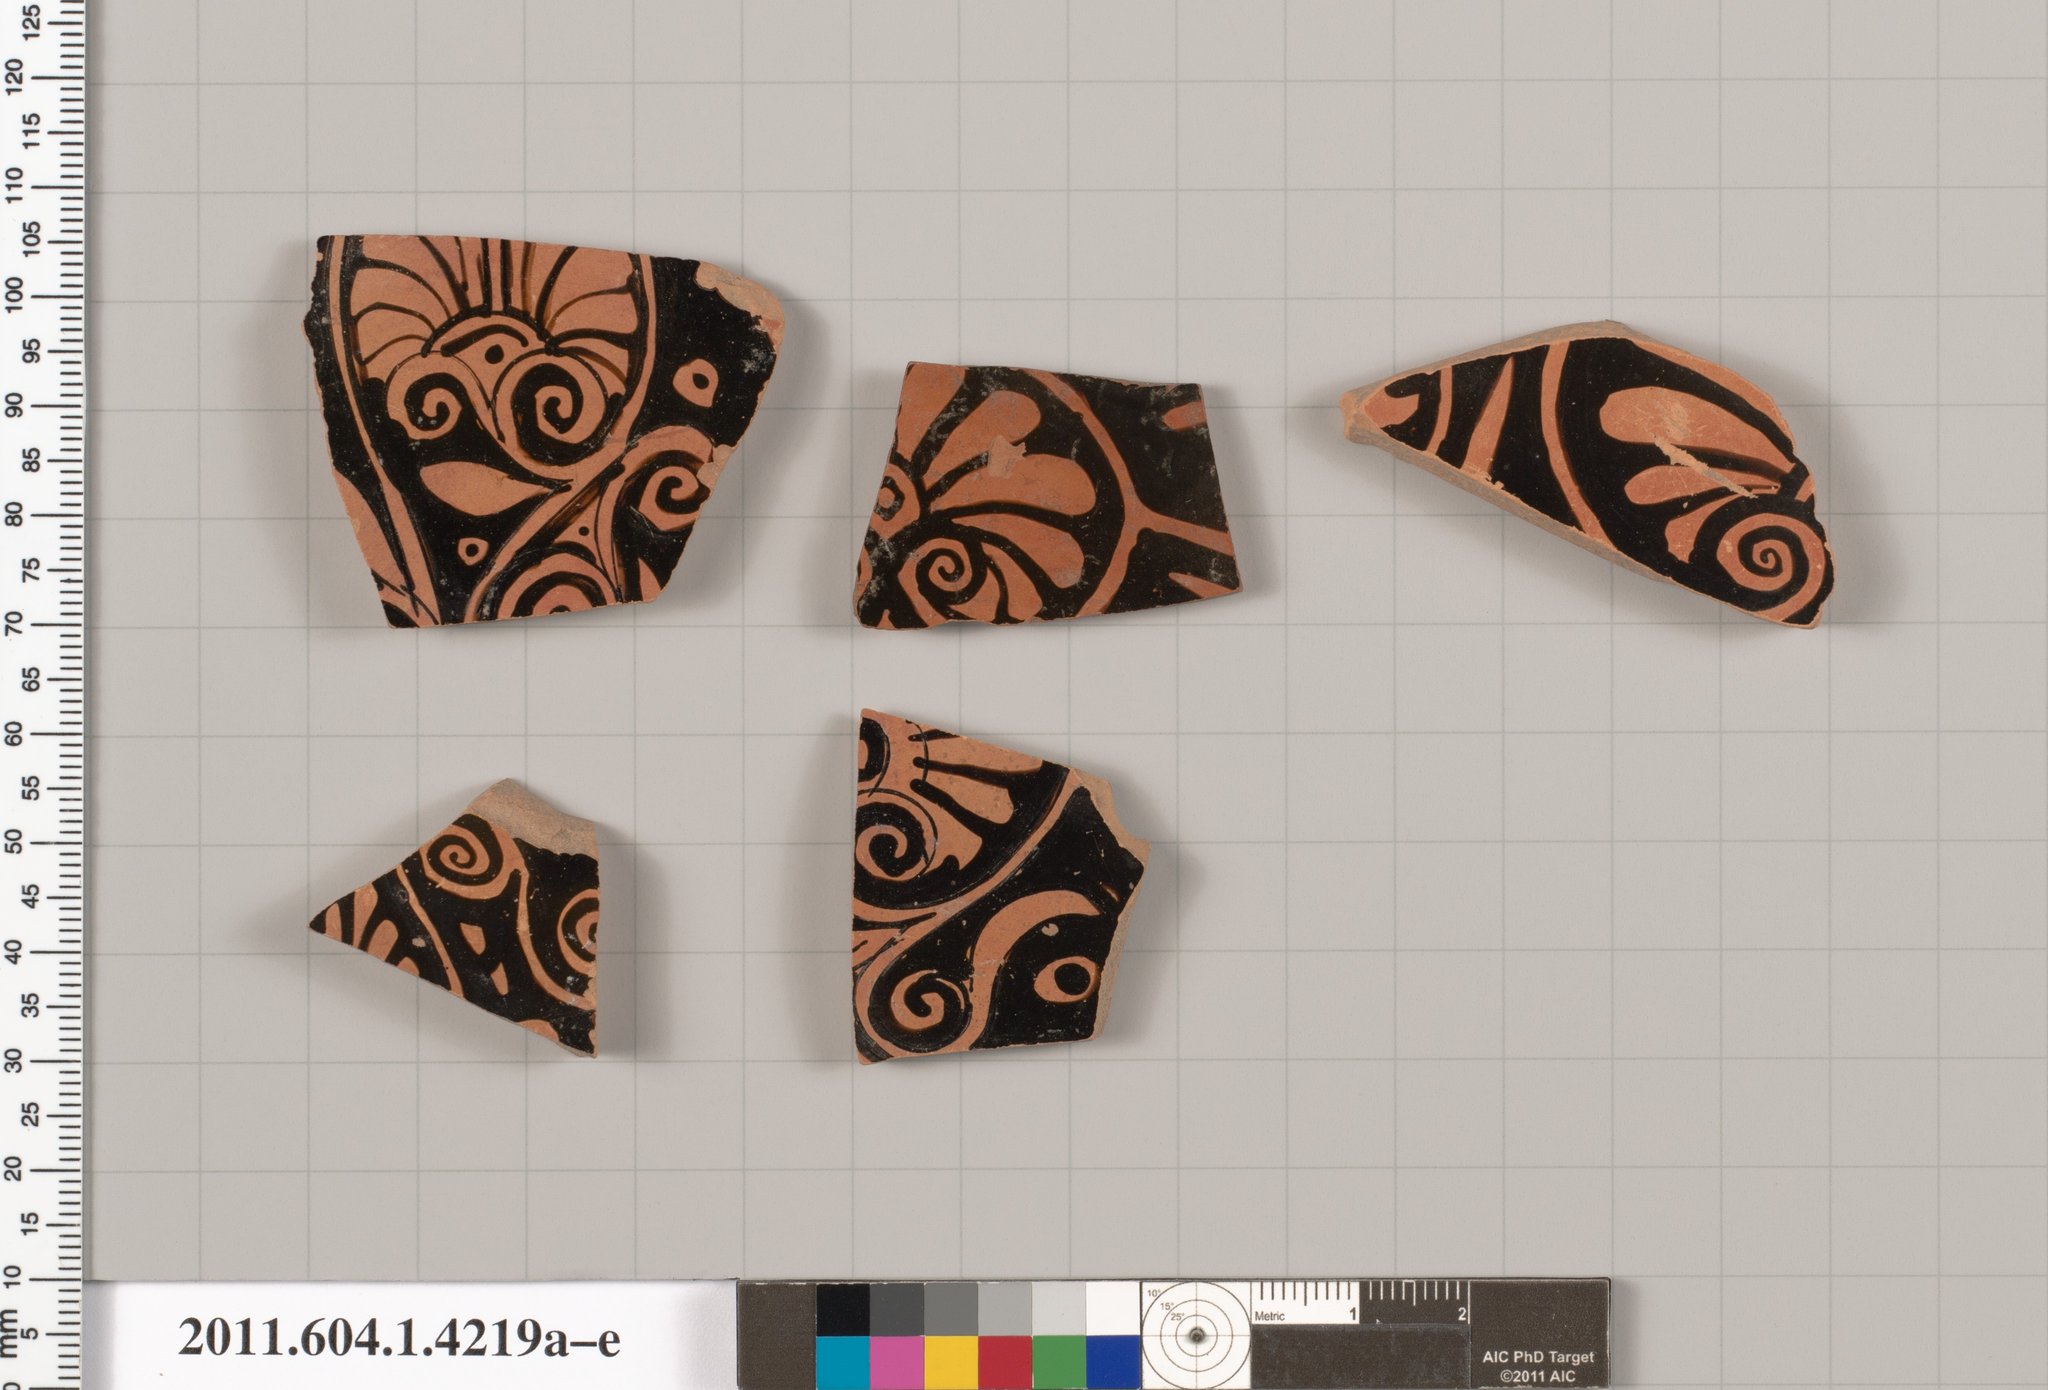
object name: kylix fragment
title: Terracotta fragments of kylikes (drinking cups)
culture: greek, attic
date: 500-451 BCE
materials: terracotta